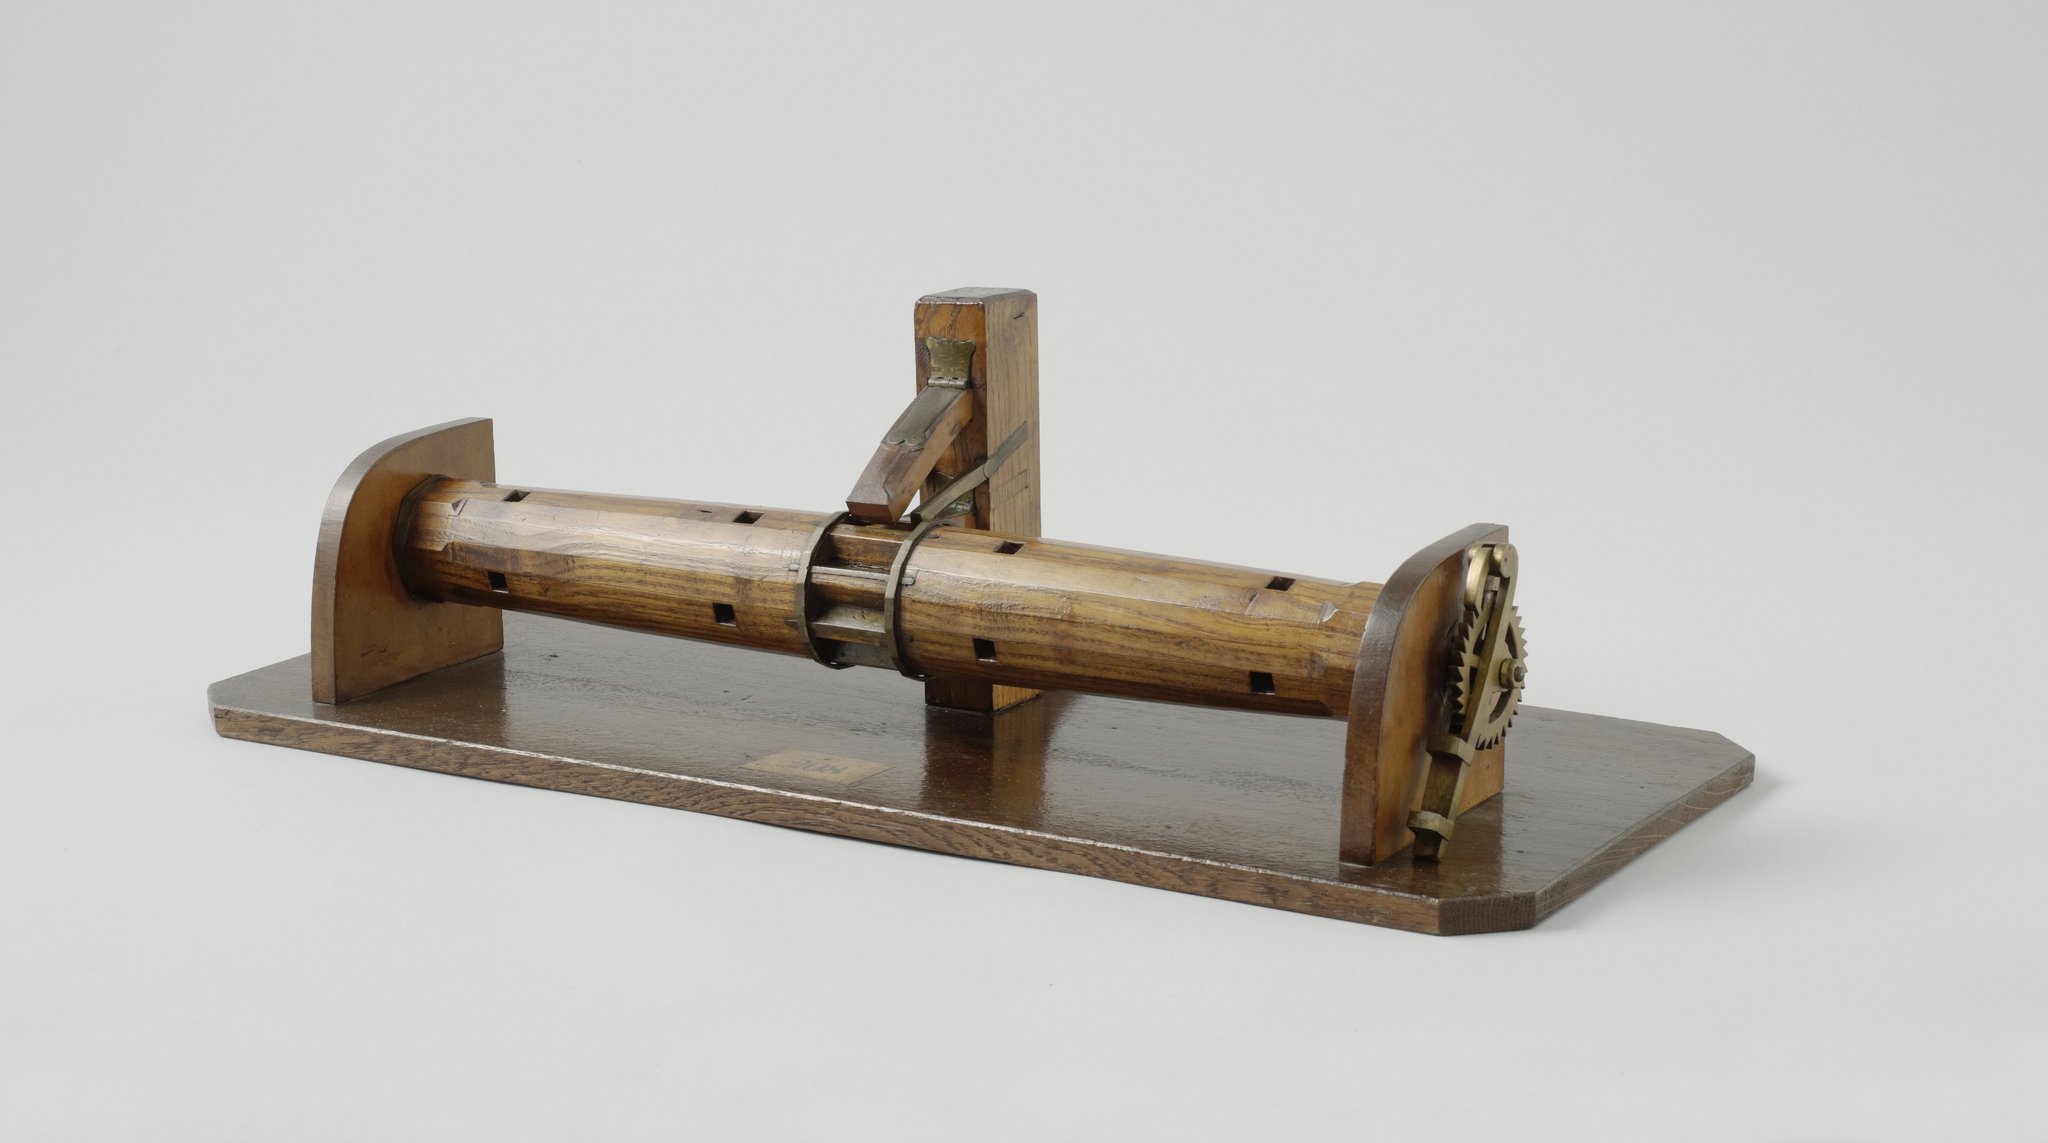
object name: demonstration model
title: Model of a Windlass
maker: Anonymous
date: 1850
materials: brass, wood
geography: netherlands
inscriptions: label, on the base: ‘208’ former inventory label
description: Model van een braadspil op een vloerplank. De trommel, tussen twee wangen opgehangen, heeft acht doorlopende gaten voor windbomen: de braadspil kan ook bediend worden met een enkele windboom aan de stuurboord wang, die met een pal in een tandwiel grijpt. In het midden staat een stut met twee houten en vier metalen pallen, die in het tandwielgedeelte van de trommel grijpen om het teruglopen te voorkomen. Schaal 1:10 (schatting).